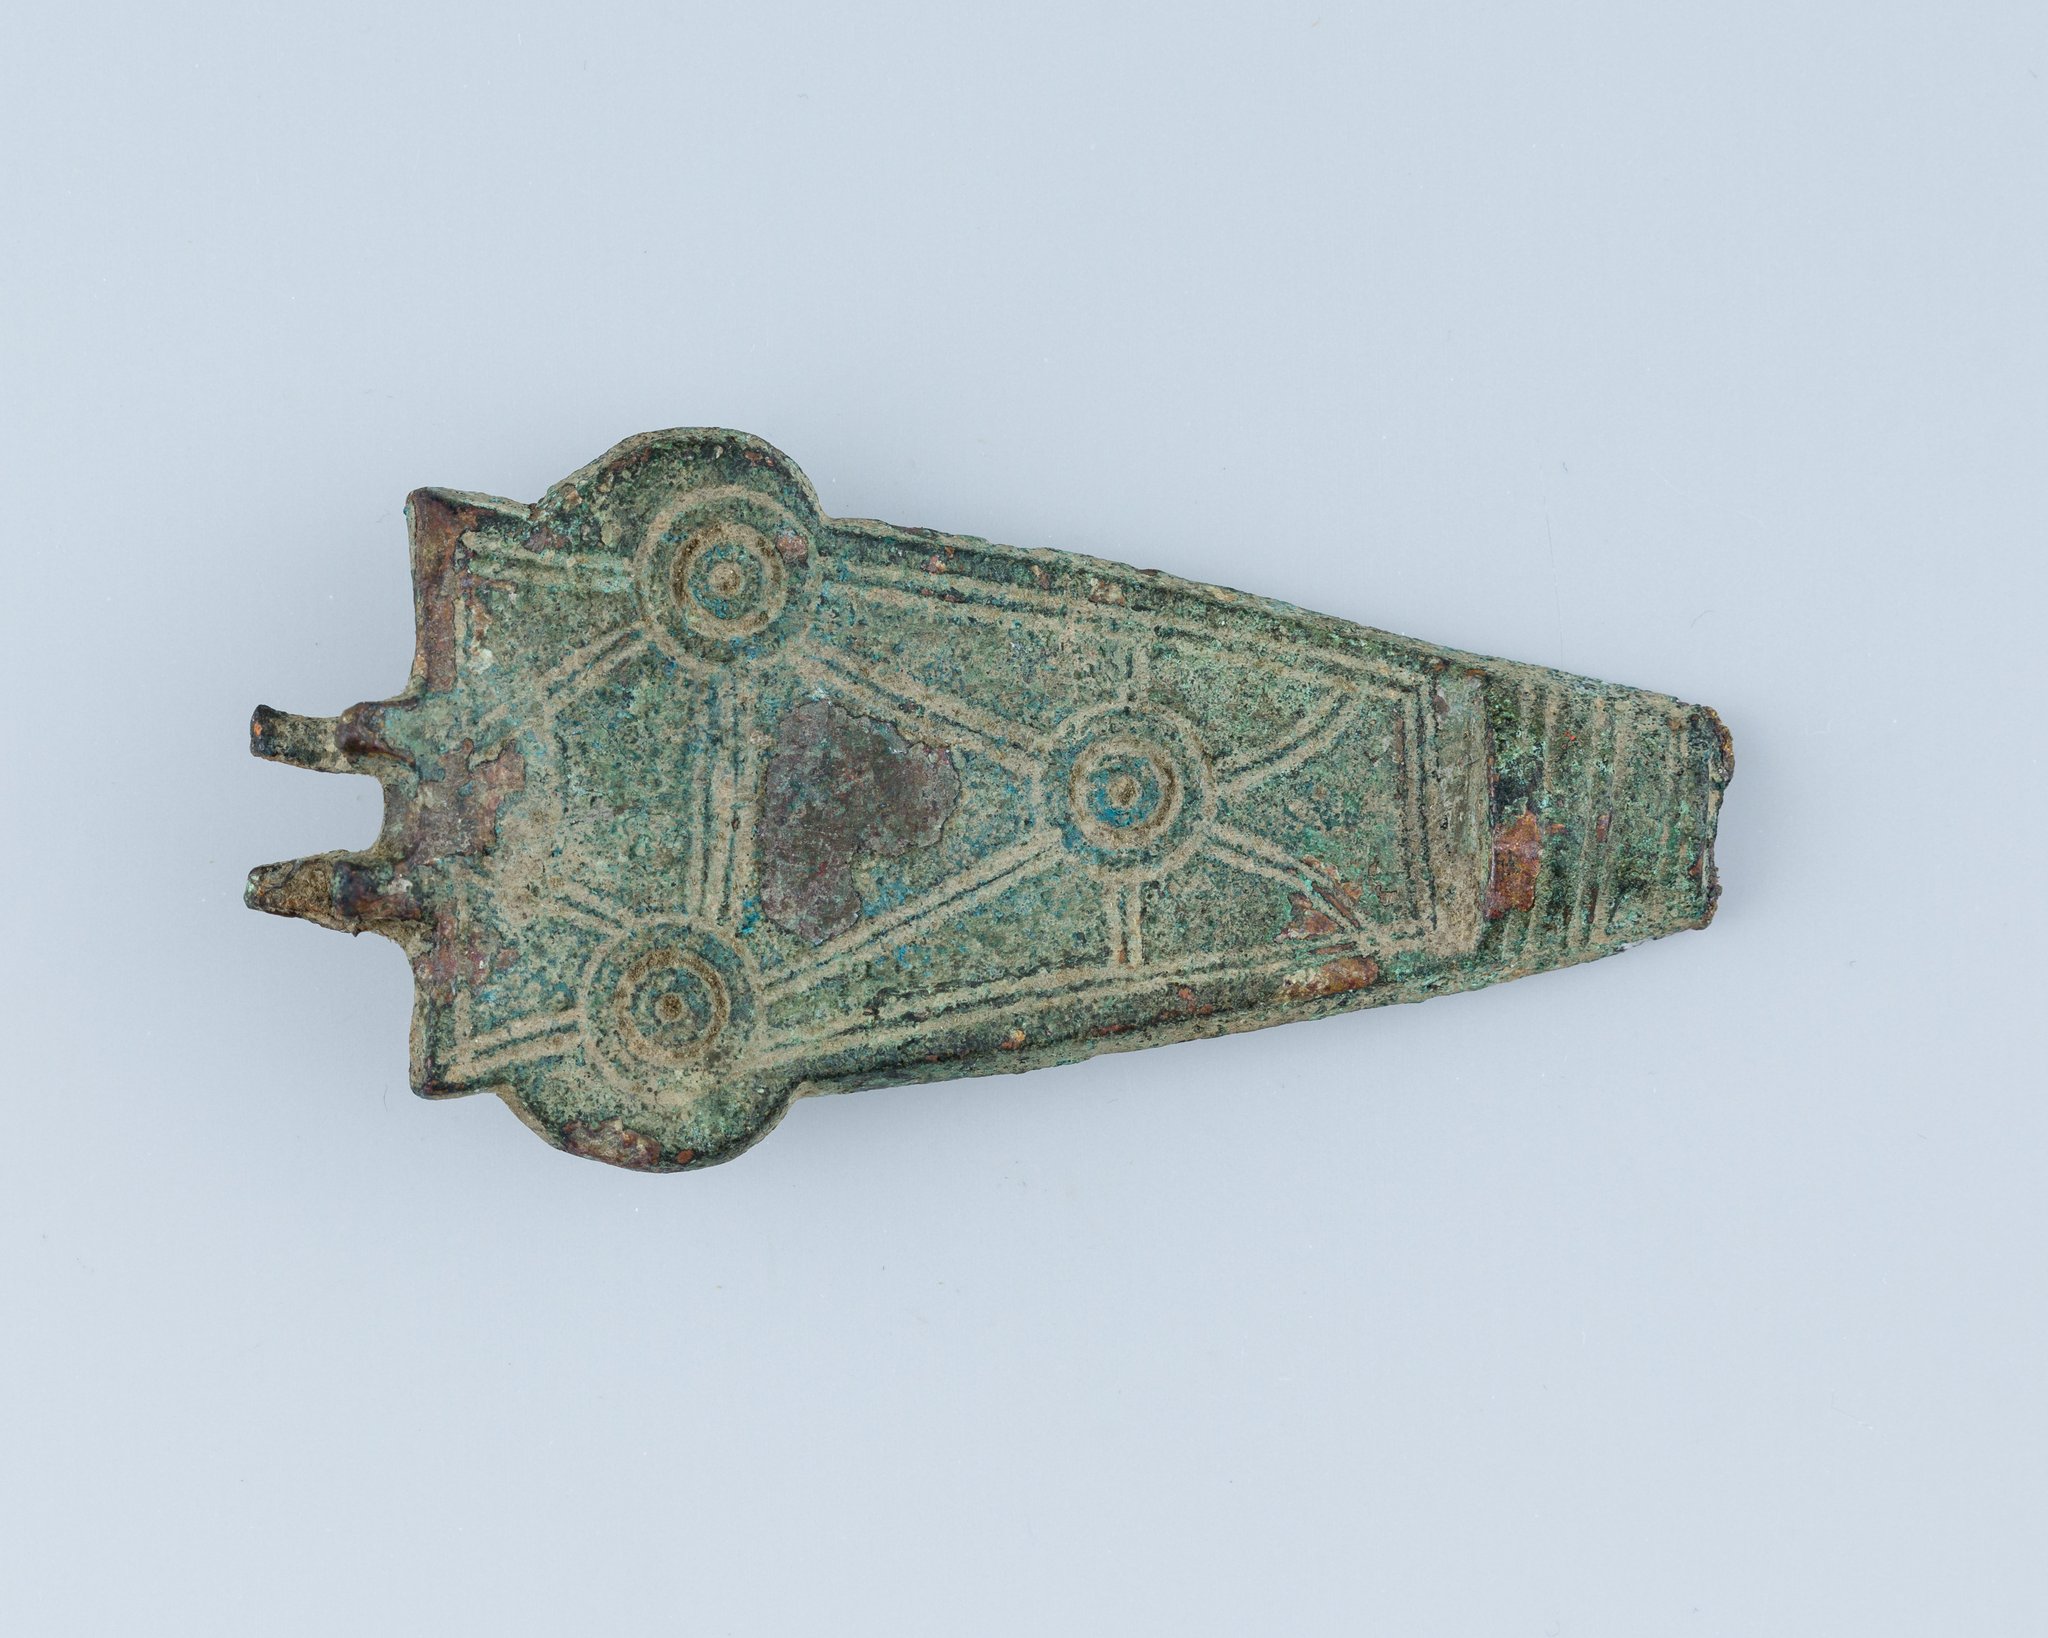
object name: buckle shank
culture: visigothic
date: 409-711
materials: bronze